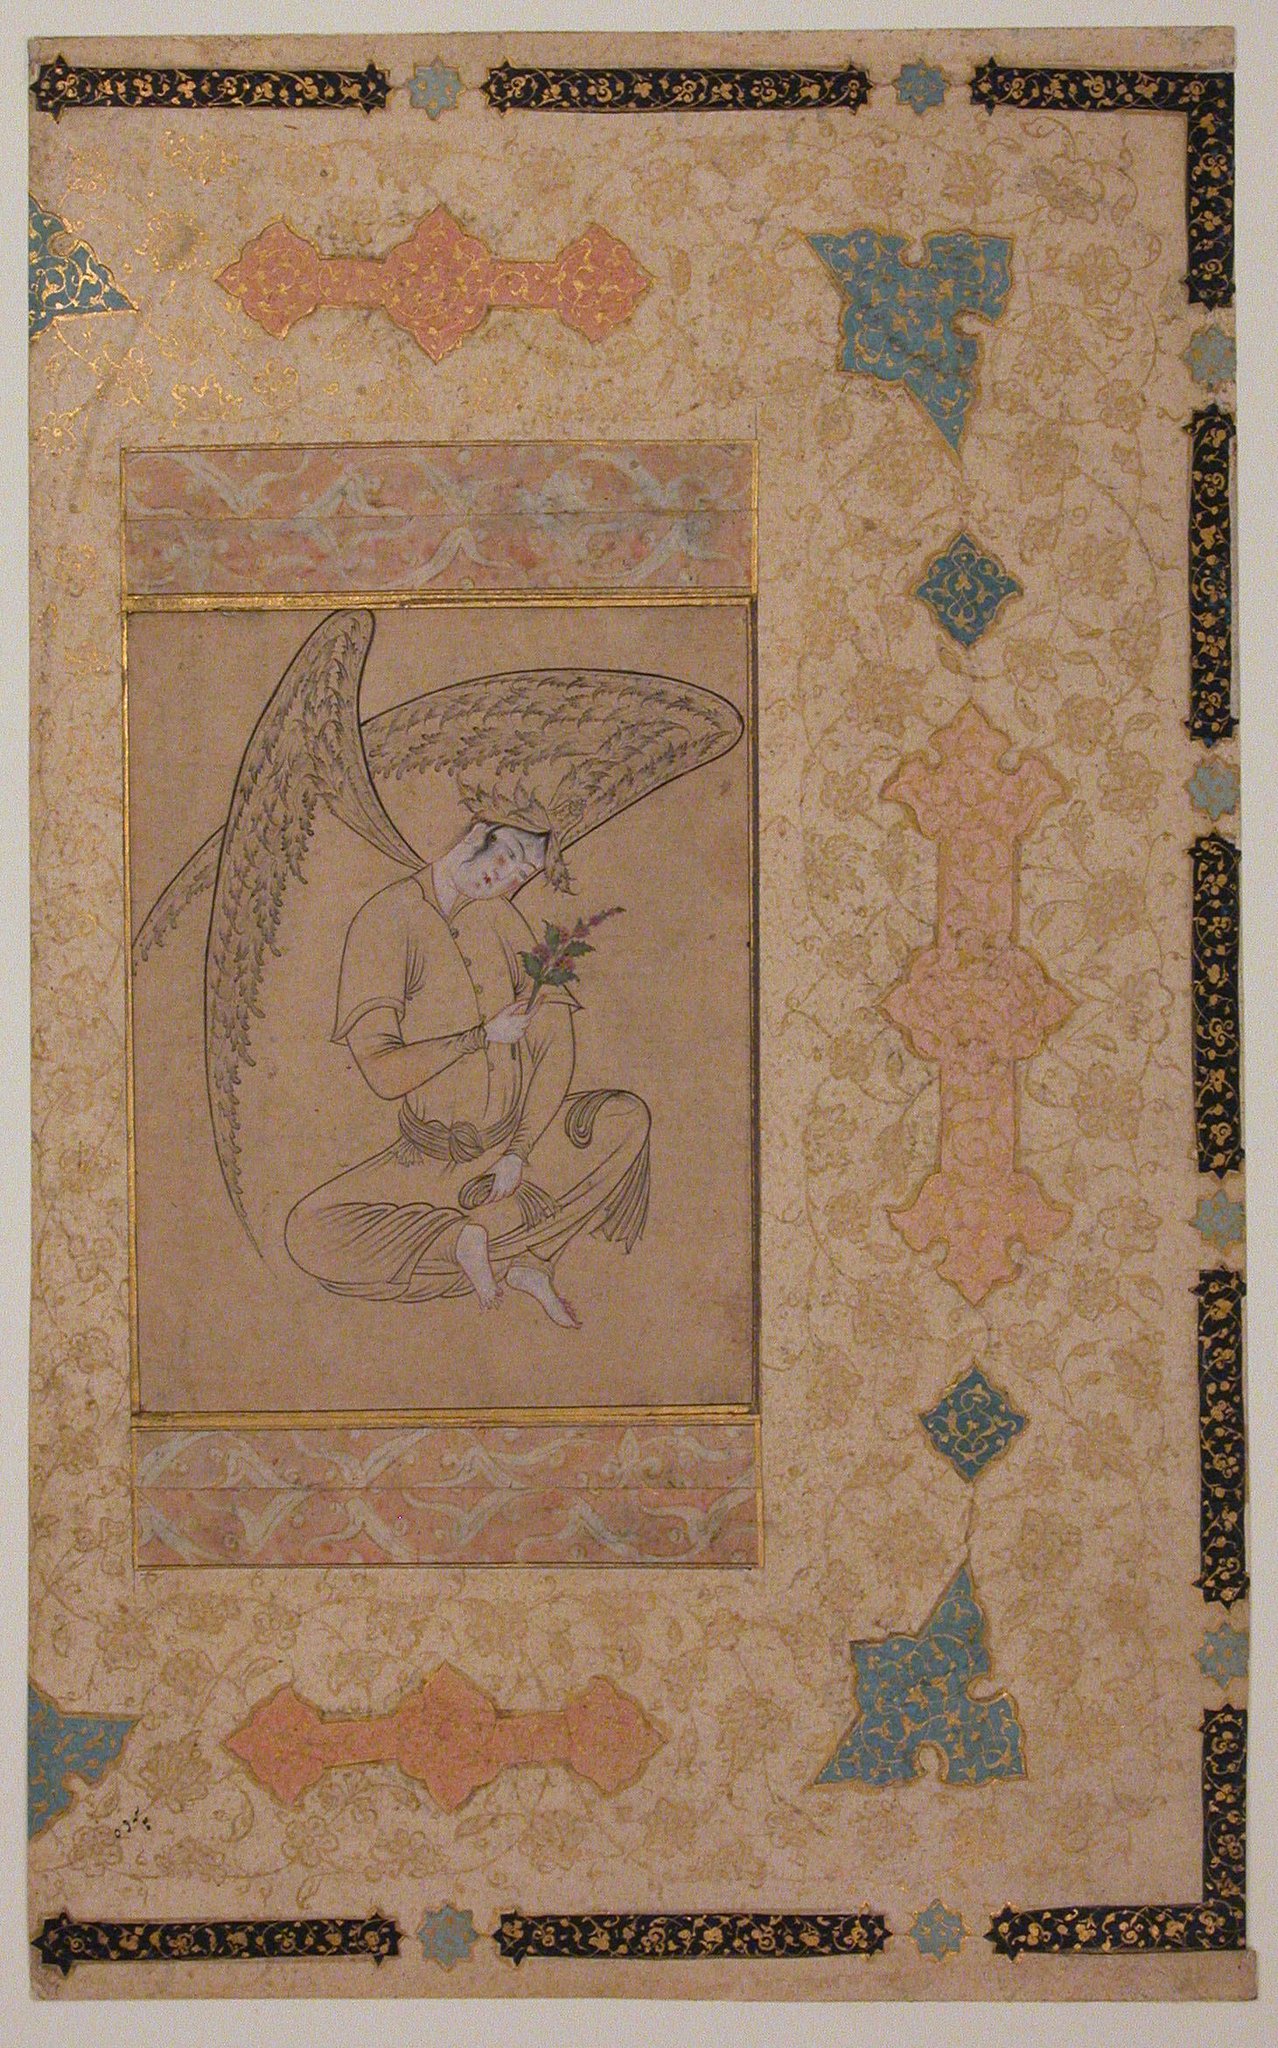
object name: album leaf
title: Seated Angel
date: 1601-1700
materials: gold, ink, paper, watercolor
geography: turkey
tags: flowers,angels